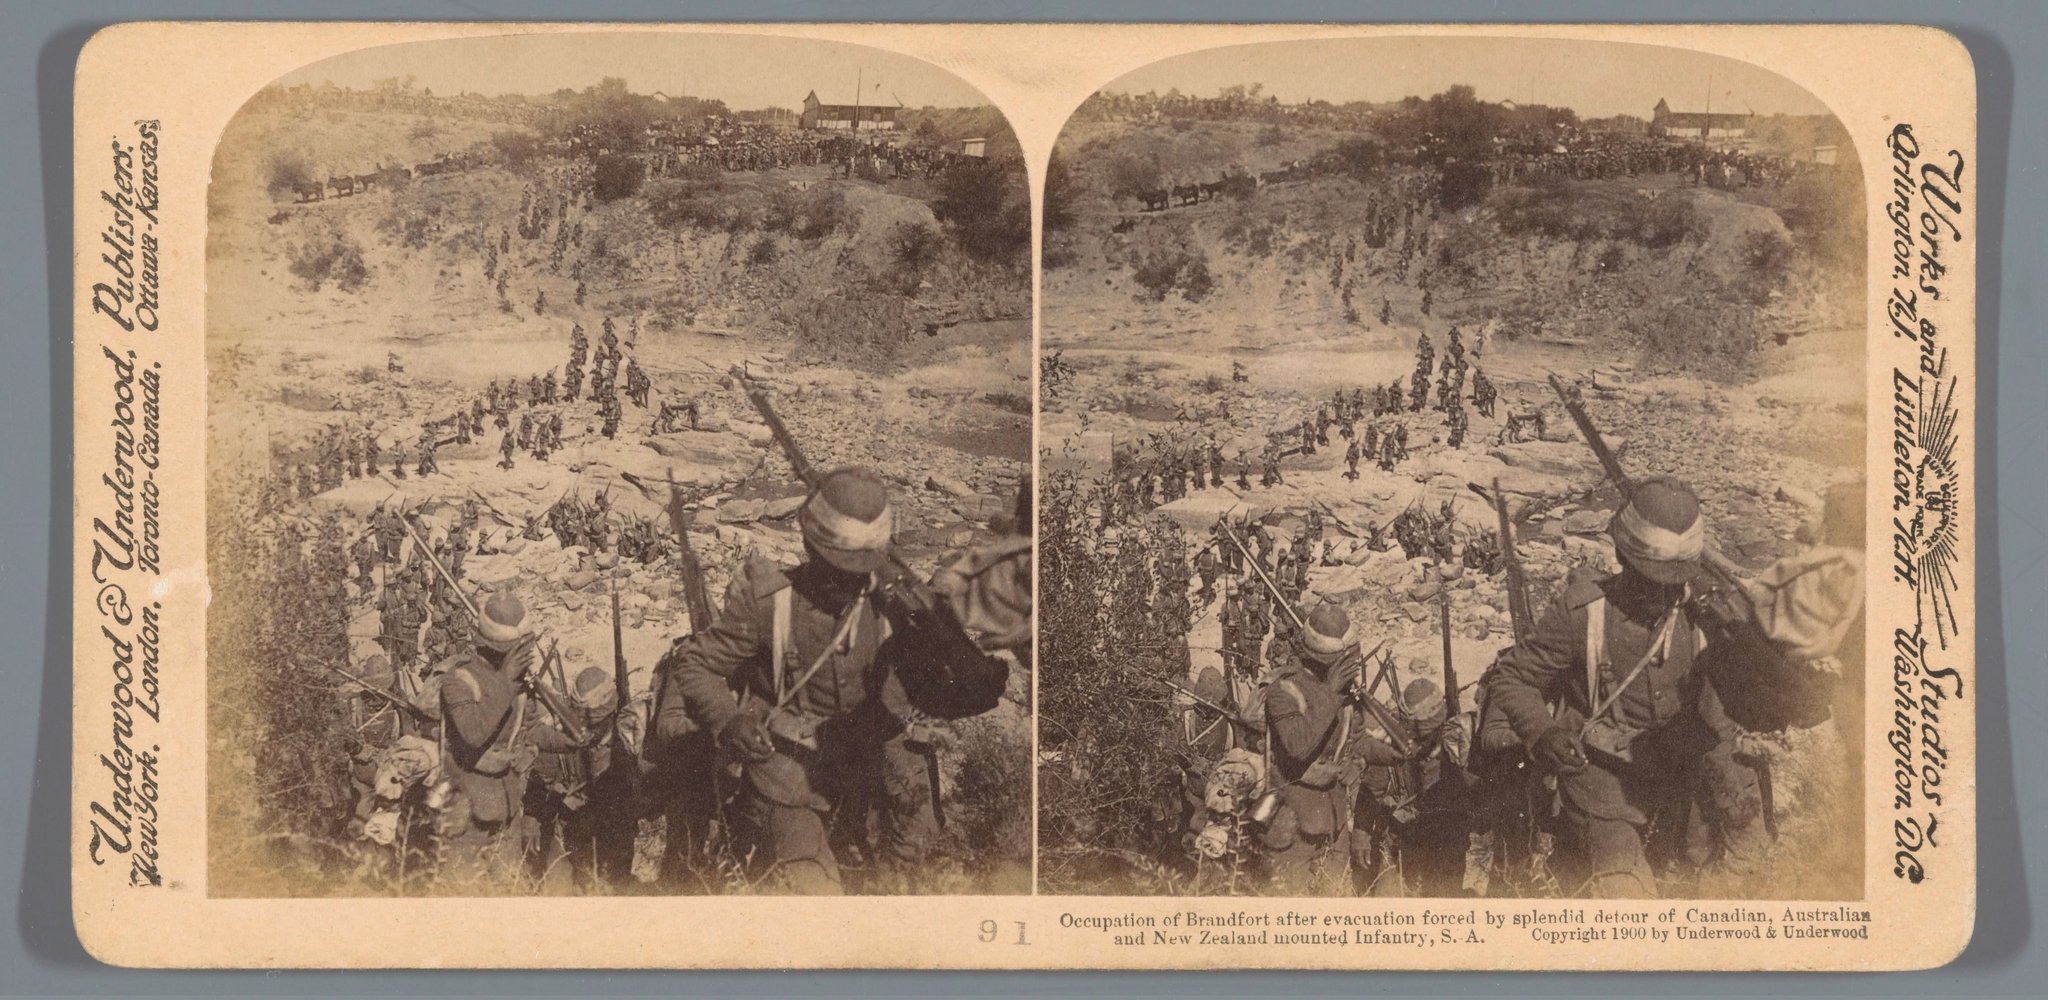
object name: stereograph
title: Occupation of Brandfort after evacuation forced by splendid detour of Canadian, Australian and New Zealand mounted infantry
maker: Anonymous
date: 1900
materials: cardboard, paper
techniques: albumen print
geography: new york city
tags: occupation ~ war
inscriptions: number: ‘91’, inscription, inscription: ‘Works and Studios ~/ Arlington, N.J. Littleton, N.H. Washington, D.C.’, copyright notice